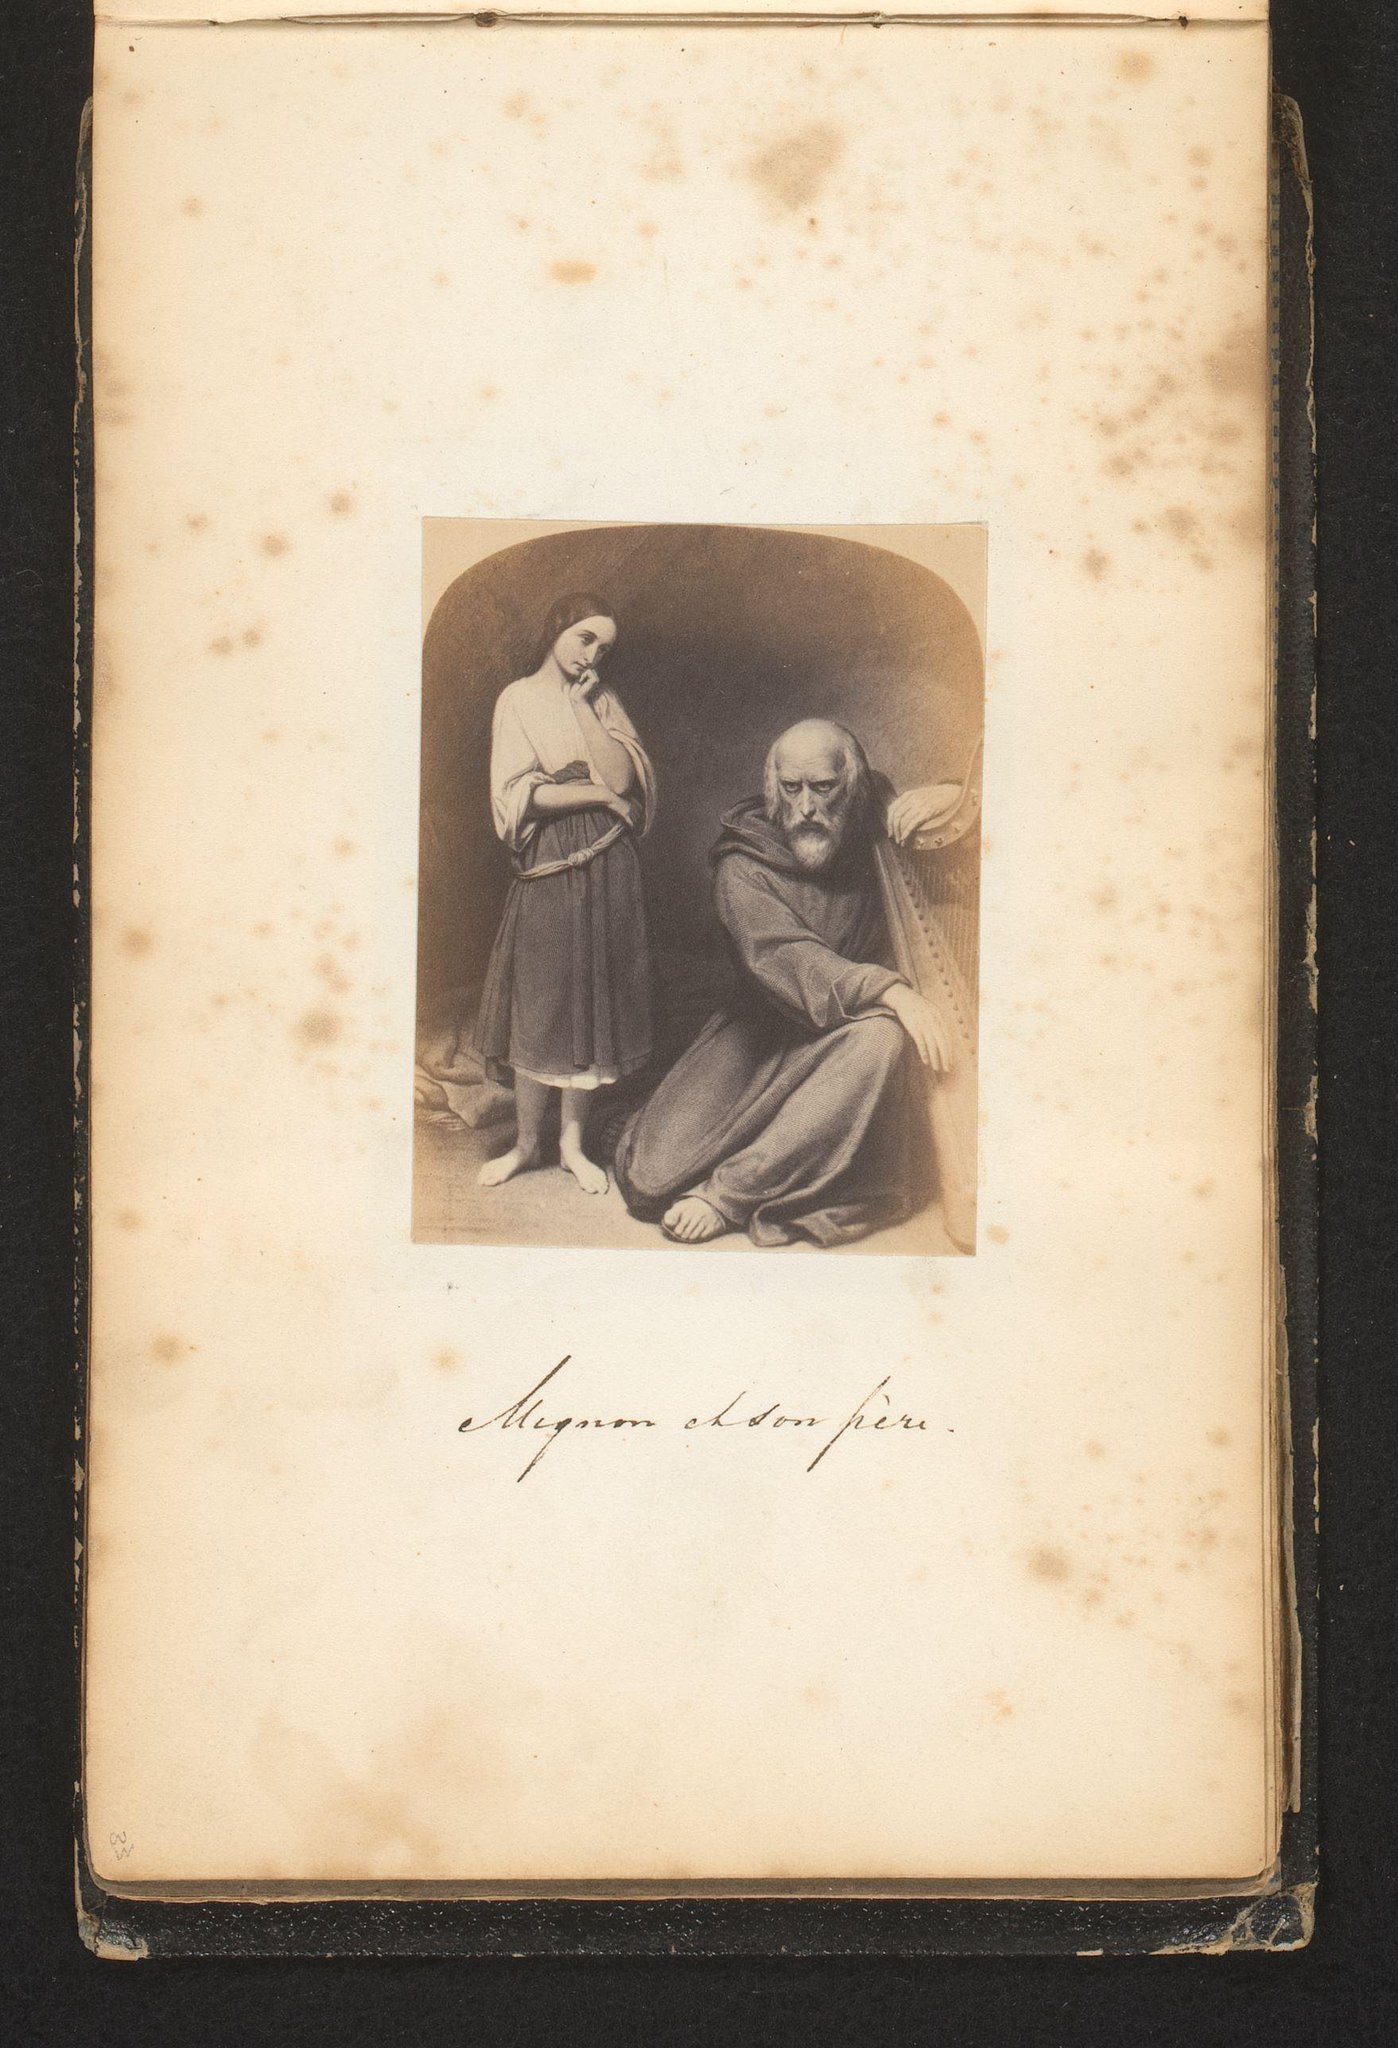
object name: photograph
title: Fotoreproductie van een mogelijke reproductie van een schilderij van een meisje met een oude monnik met een harp naar Ary Scheffer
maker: Anonymous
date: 1860-1900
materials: photographic support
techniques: albumen print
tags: monk(s), friar(s), girl (child between toddler and youth), harp, painting, drawing and the graphic arts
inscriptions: annotation: ‘[...]’